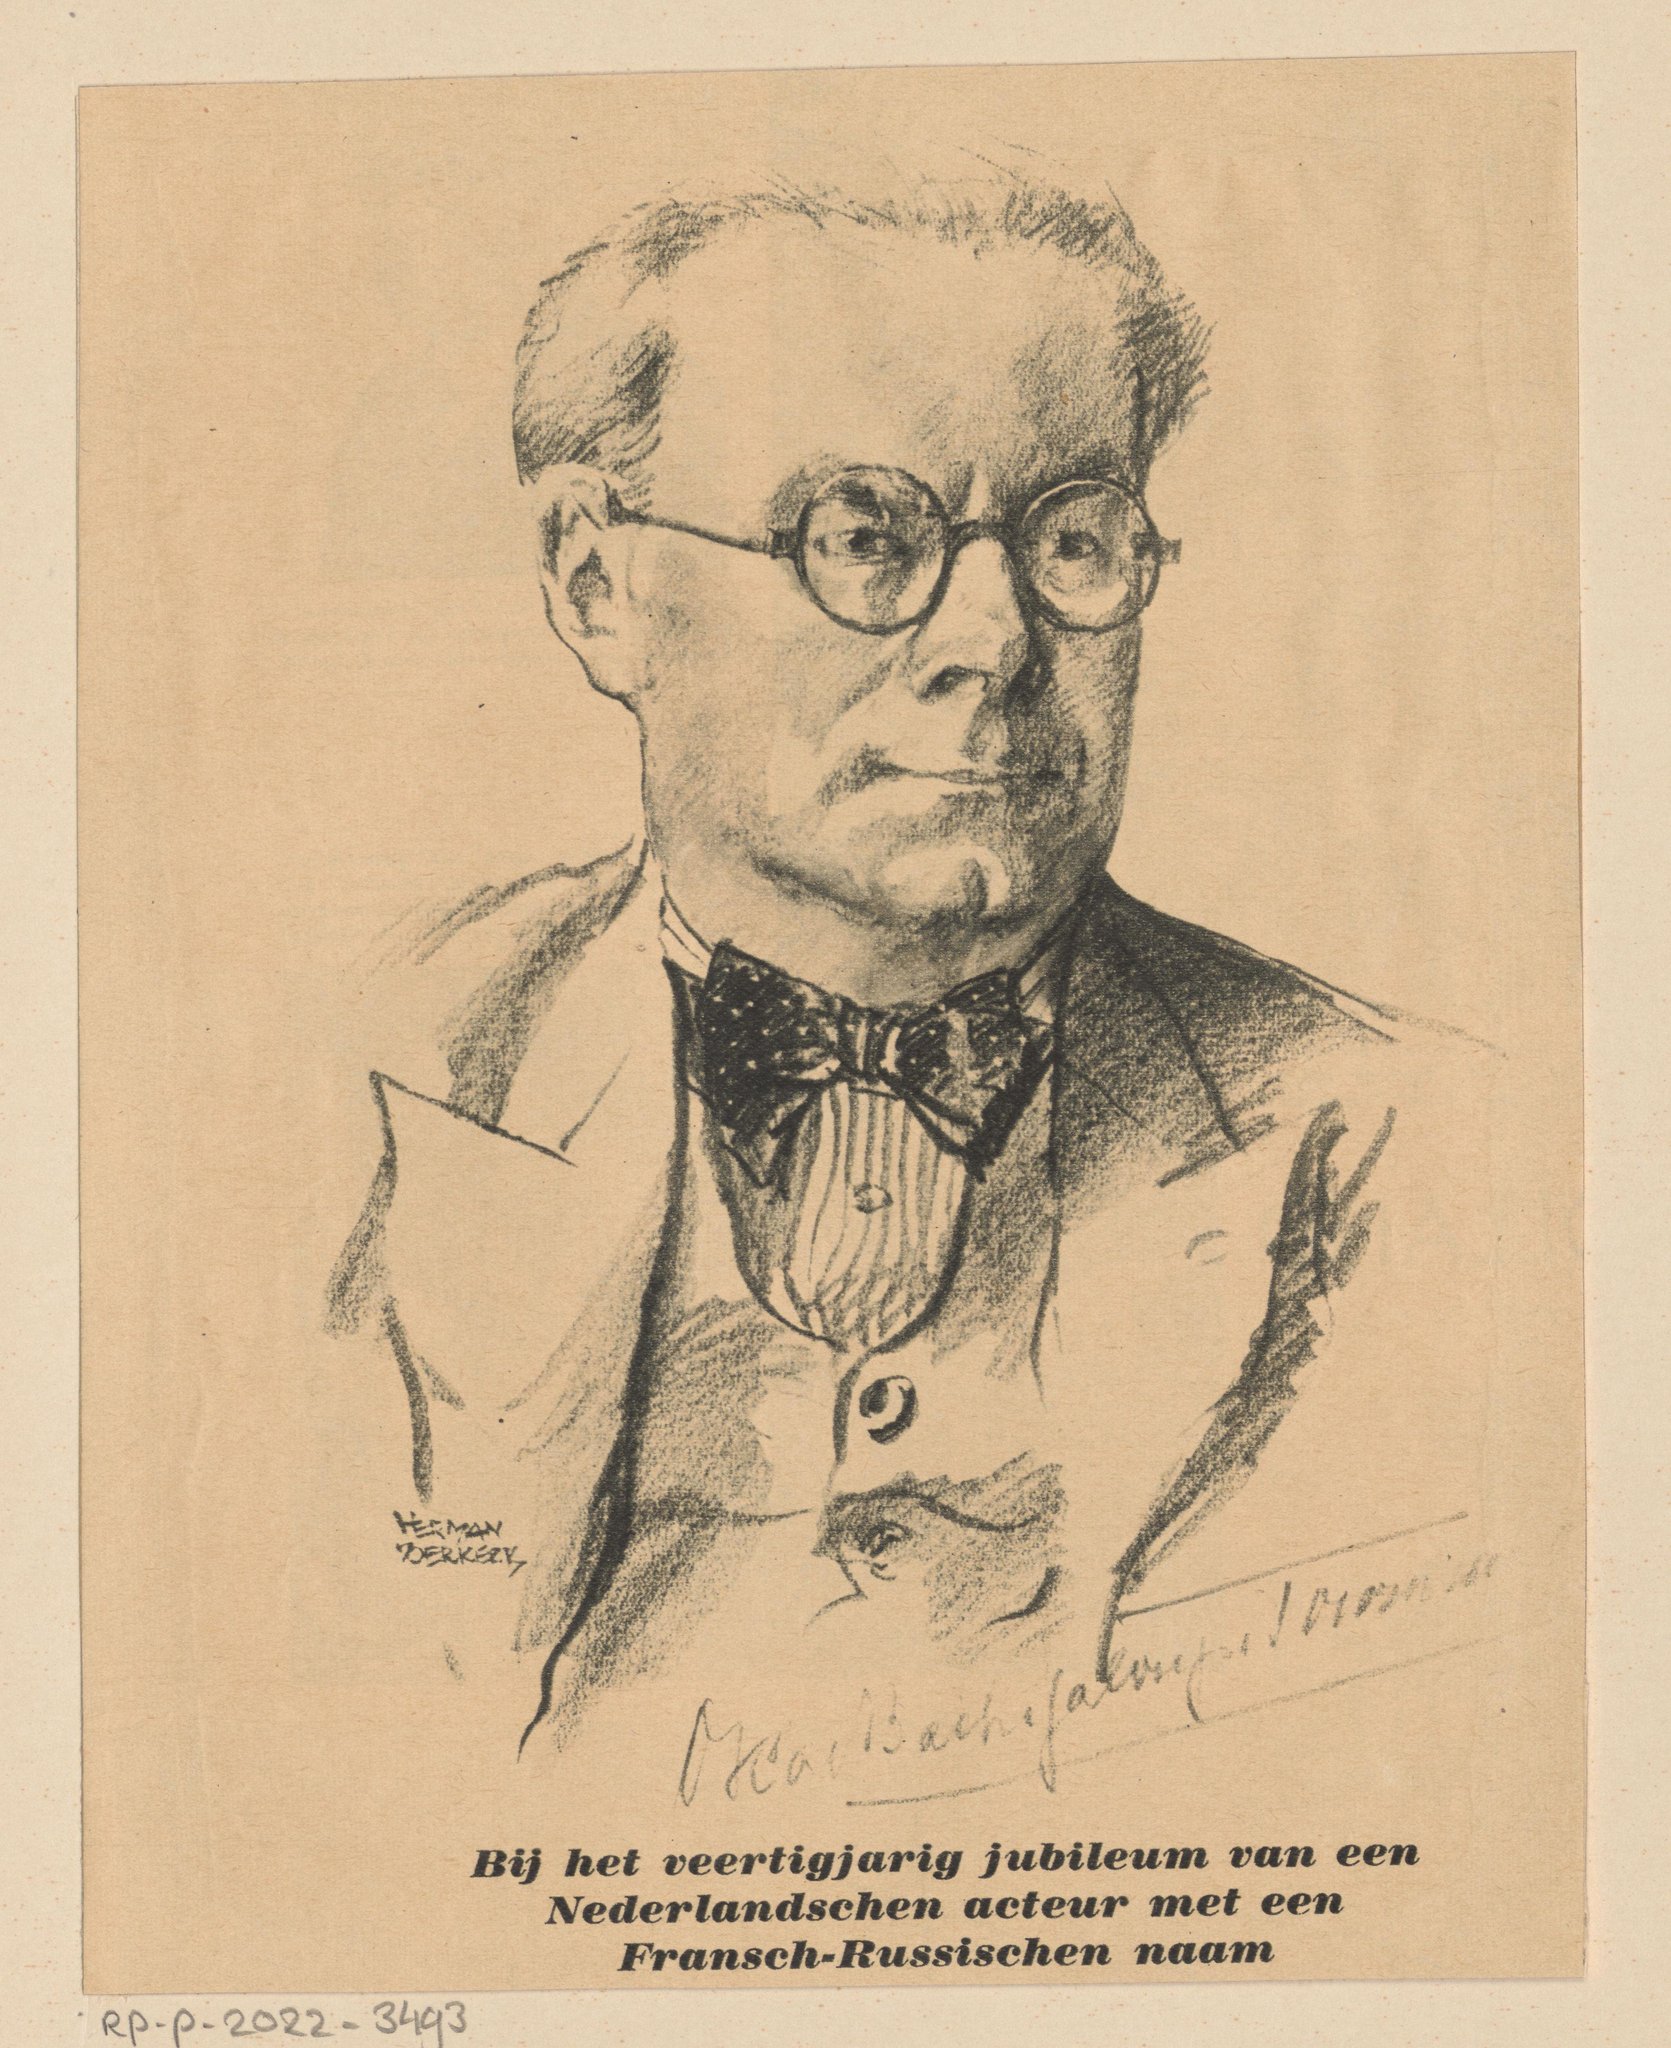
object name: photomechanical print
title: Portret van Oscar Tourniaire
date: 1937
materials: paper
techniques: photochemical processes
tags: amsterdam, historical persons, portrait of actor, actress